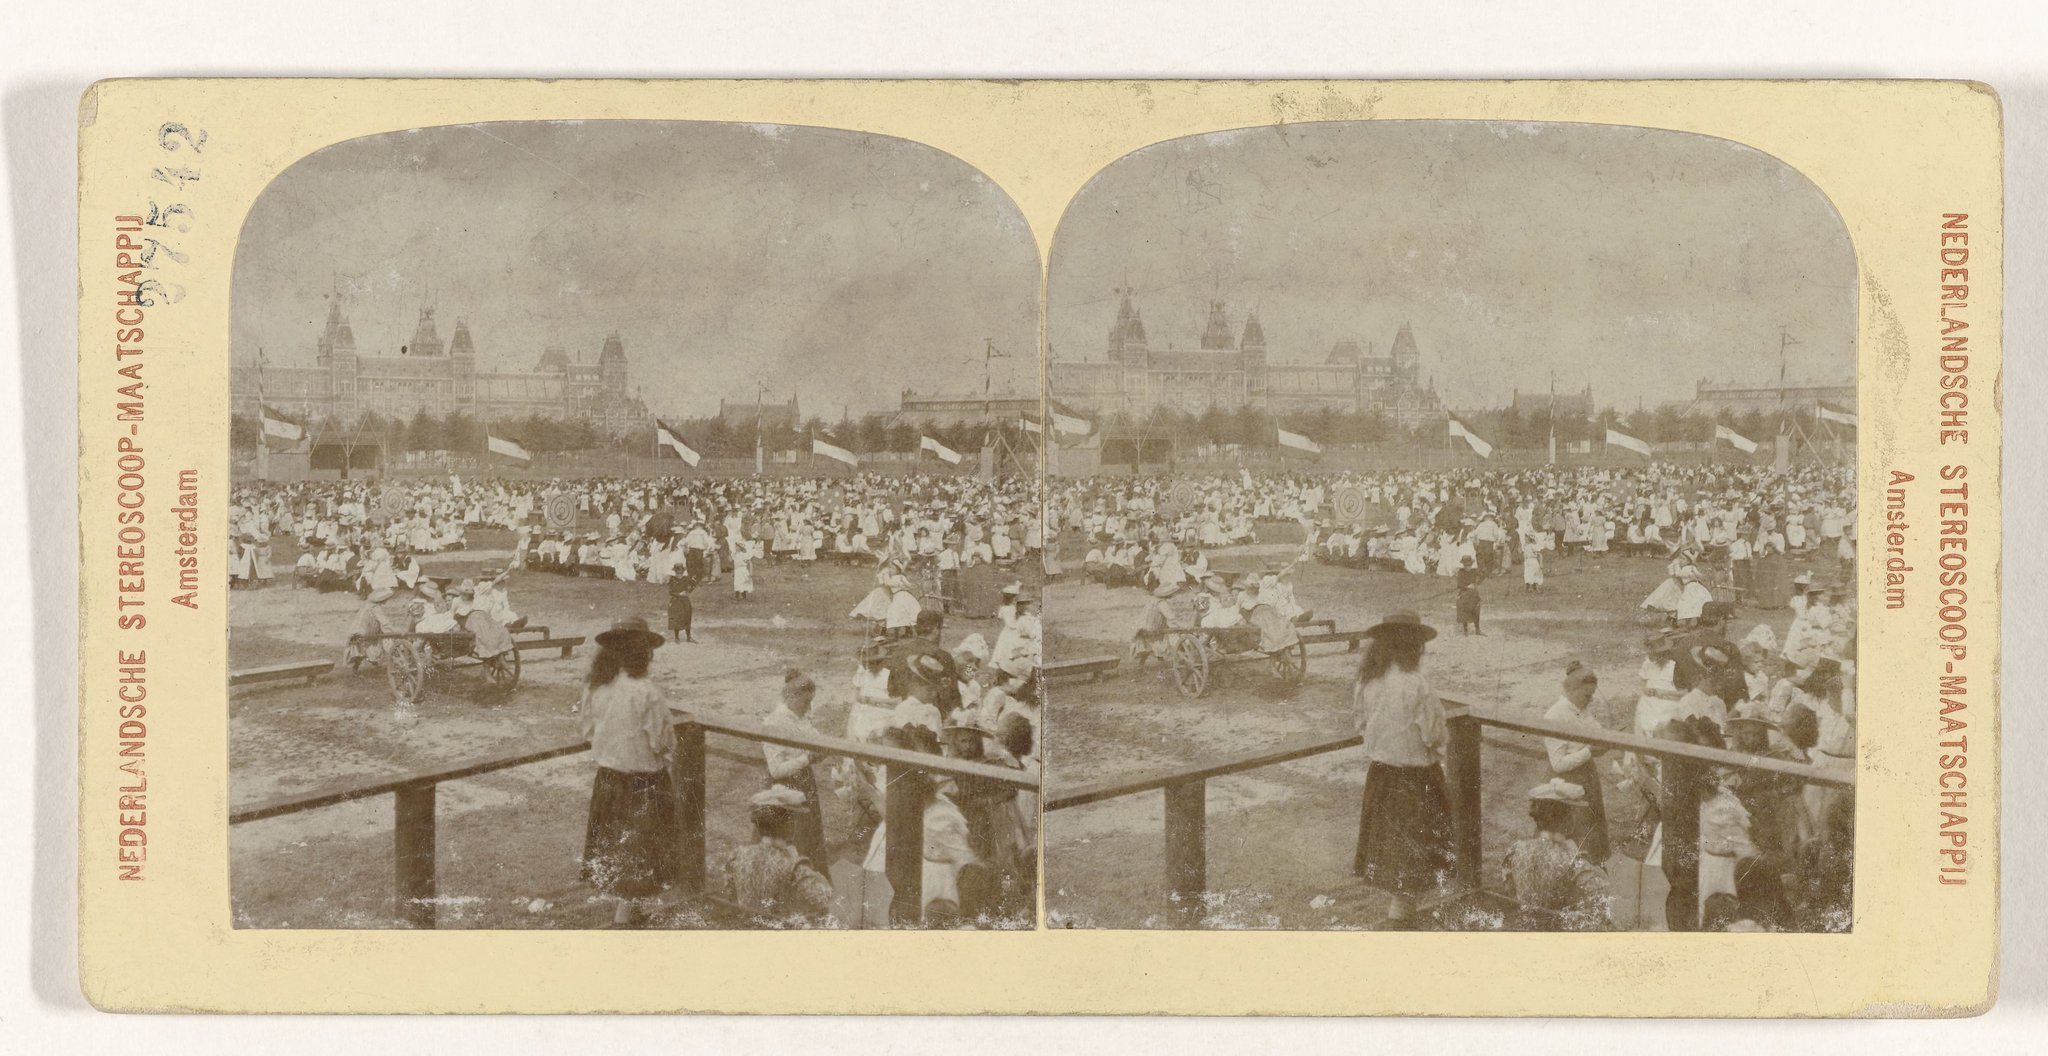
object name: stereograph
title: Feestelijkheden op het Museumplein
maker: j.g. beers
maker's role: fotograaf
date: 1897-1910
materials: paper, cardboard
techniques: collodion silver print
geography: amsterdam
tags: square, place, circus, etc., rejoicing on special occasions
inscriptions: stamp: ‘27542’